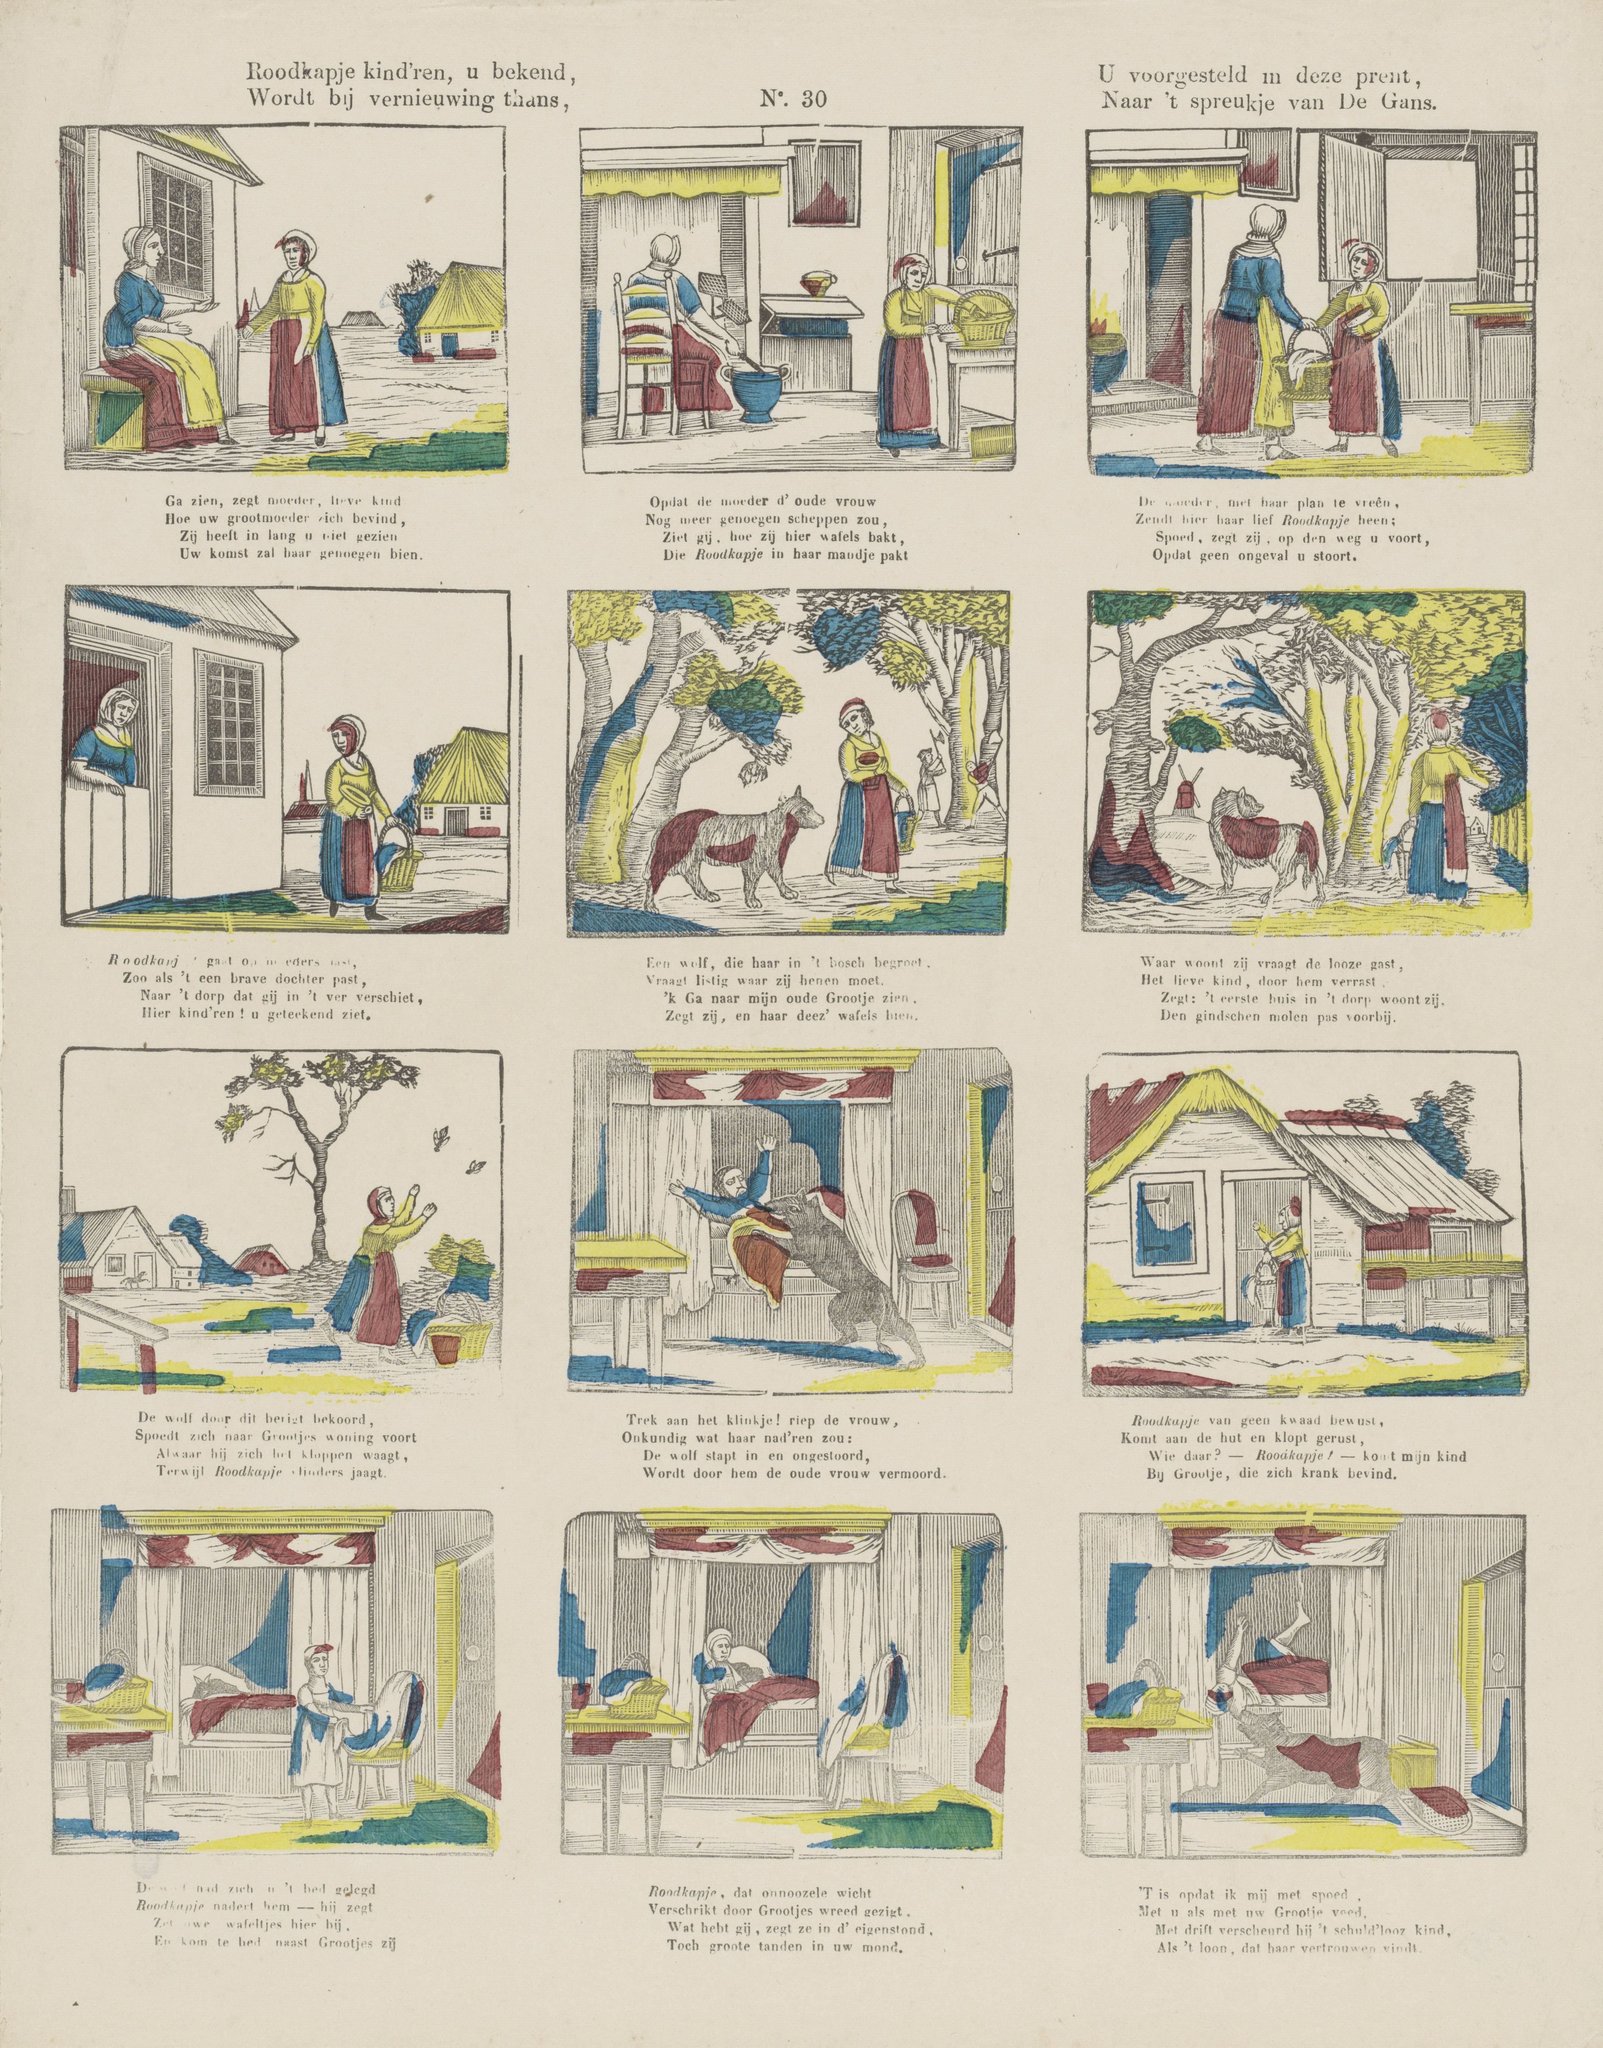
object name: popular print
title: Roodkapje kind'ren, u bekend / Wordt bij vernieuwing thans / U voorgesteld in deze prent / Naar 't spreukje van de gans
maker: Anonymous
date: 1848-1881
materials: paper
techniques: colour, letterpress printing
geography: netherlands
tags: tales and fairy tales: little red riding-hood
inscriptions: collector's mark: Lugt 2760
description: Blad met 12 voorstellingen uit het sprookje van Roodkapje. Onder elke voorstelling een vierregelig vers. Genummerd midden boven: No. 30.